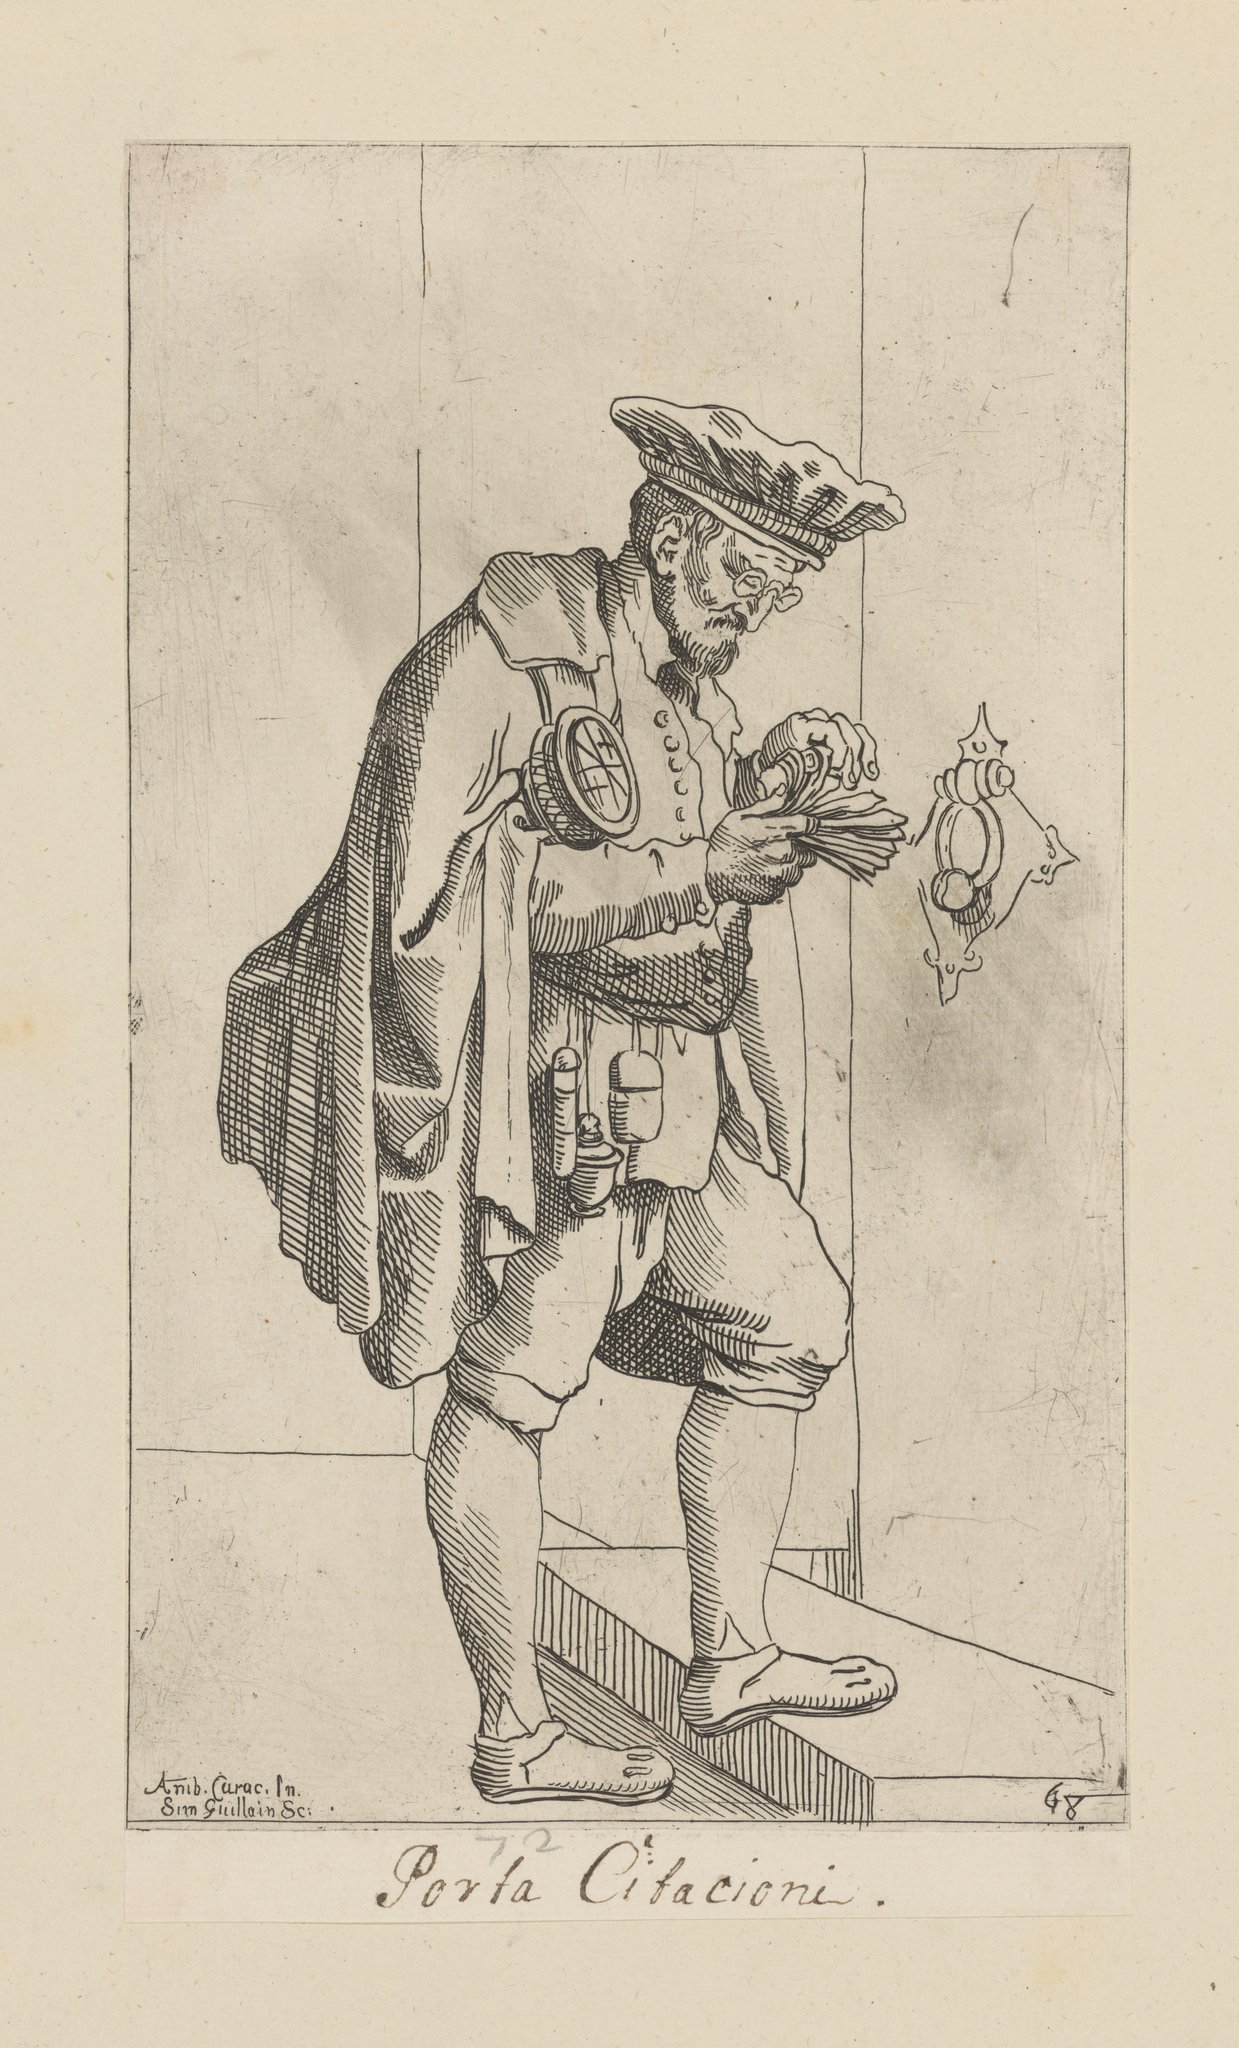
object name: print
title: Plate 68: Server of summons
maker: simon guillain ii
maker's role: artist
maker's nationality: french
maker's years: 1618-1718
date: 1646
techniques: etching